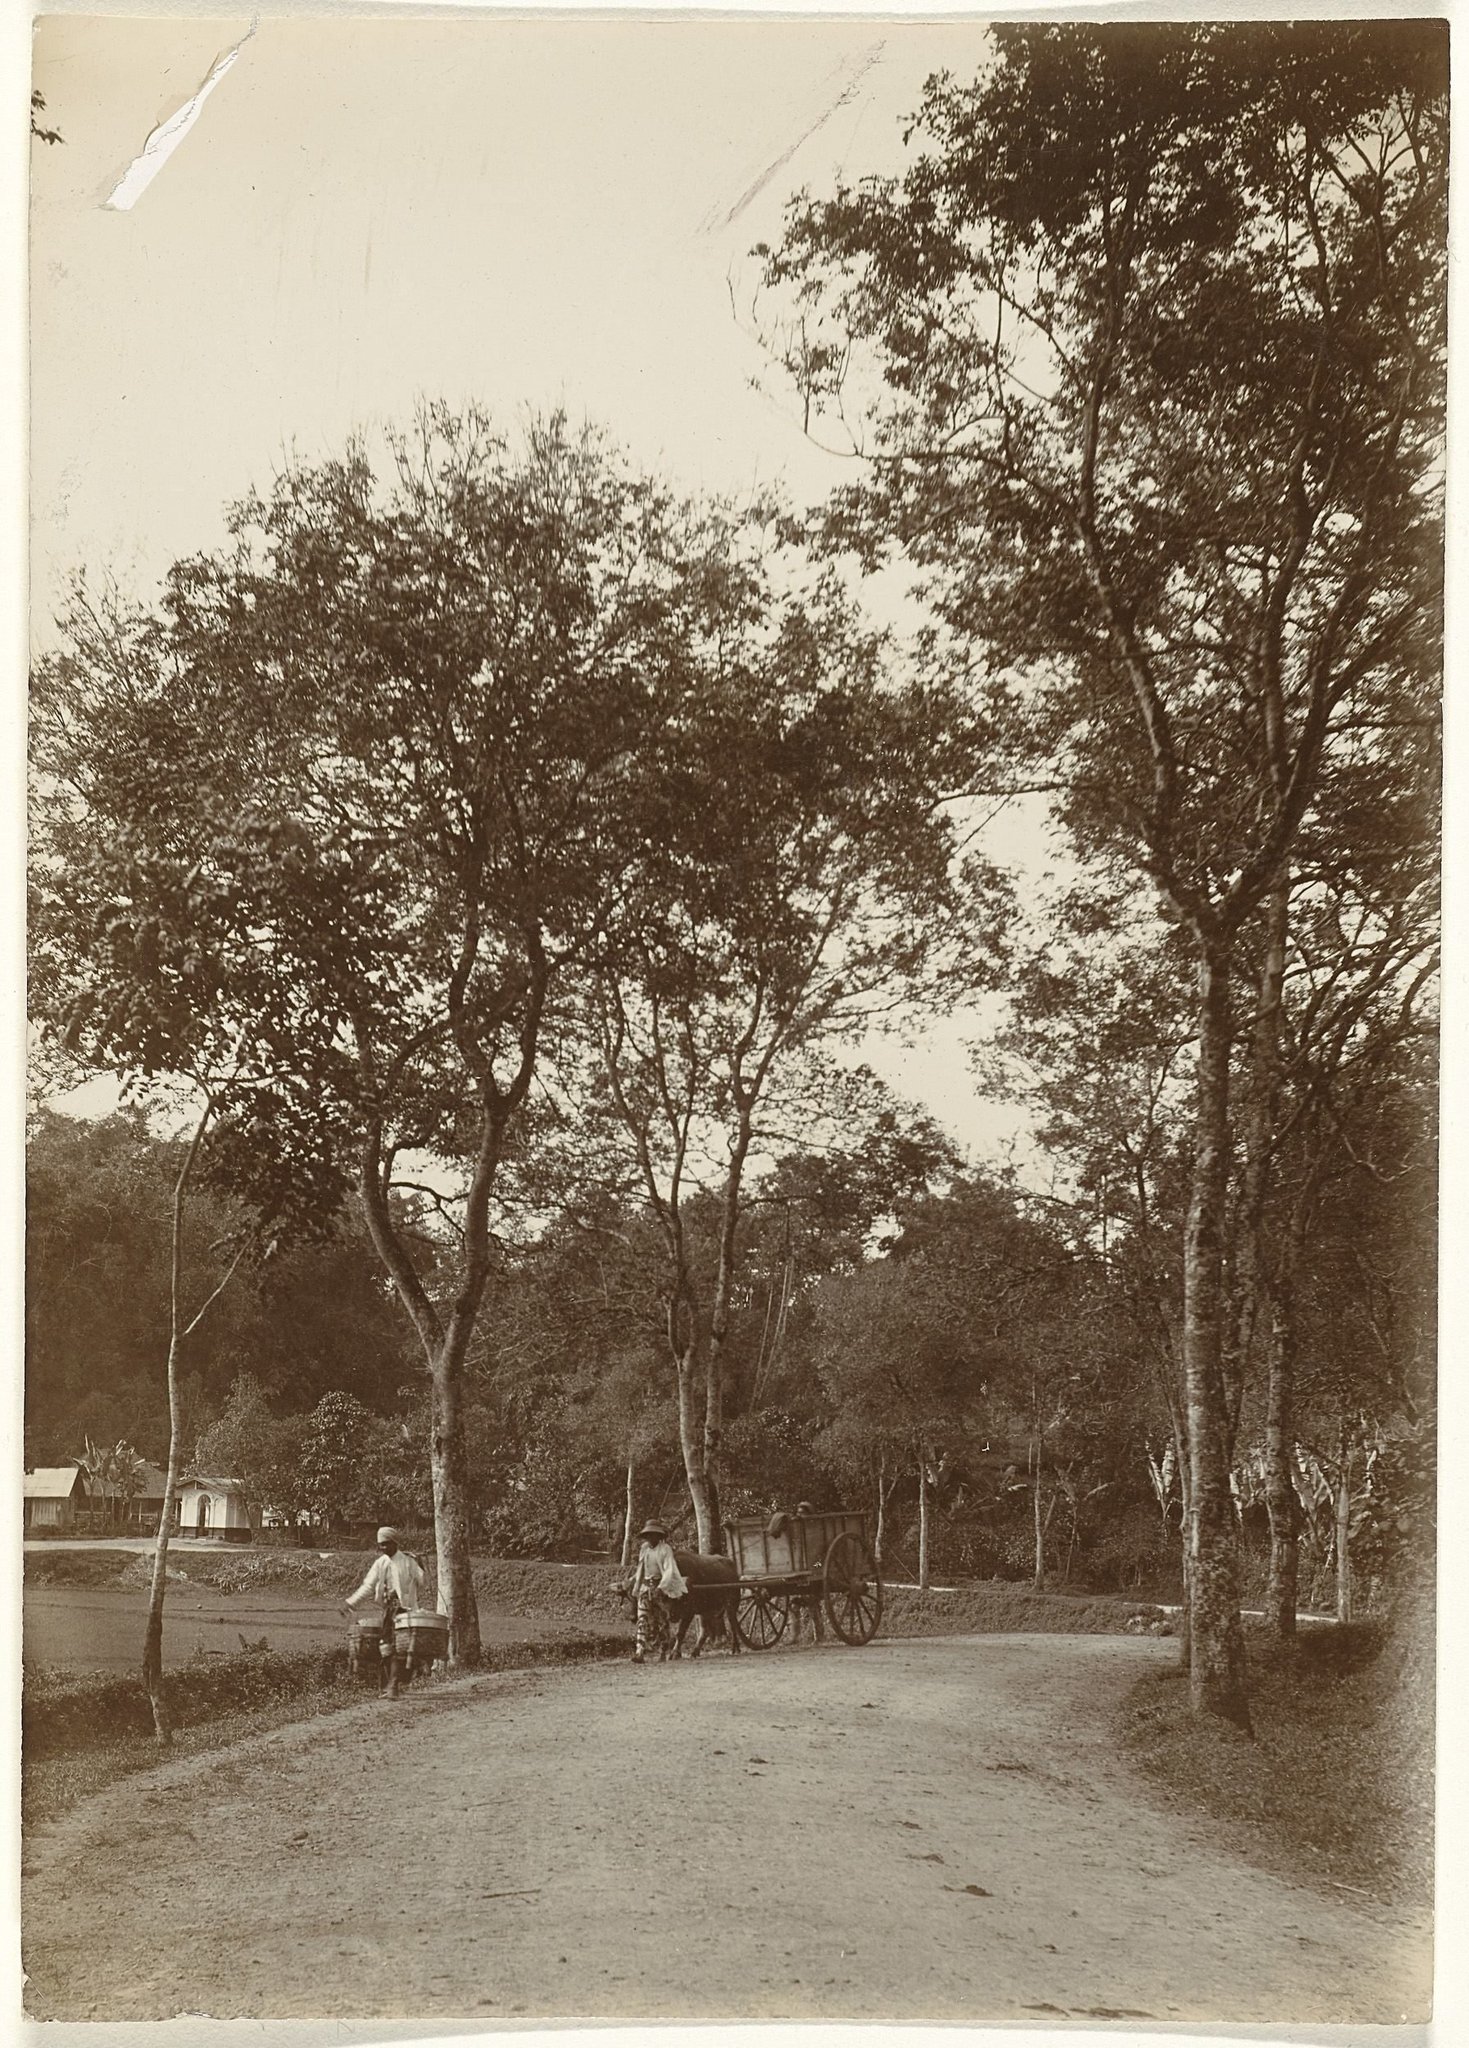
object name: photograph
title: Singel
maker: Anonymous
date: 1890-1920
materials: paper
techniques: gelatin silver print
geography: indonesia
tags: public road, indonesia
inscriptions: inscription: ‘Singel’